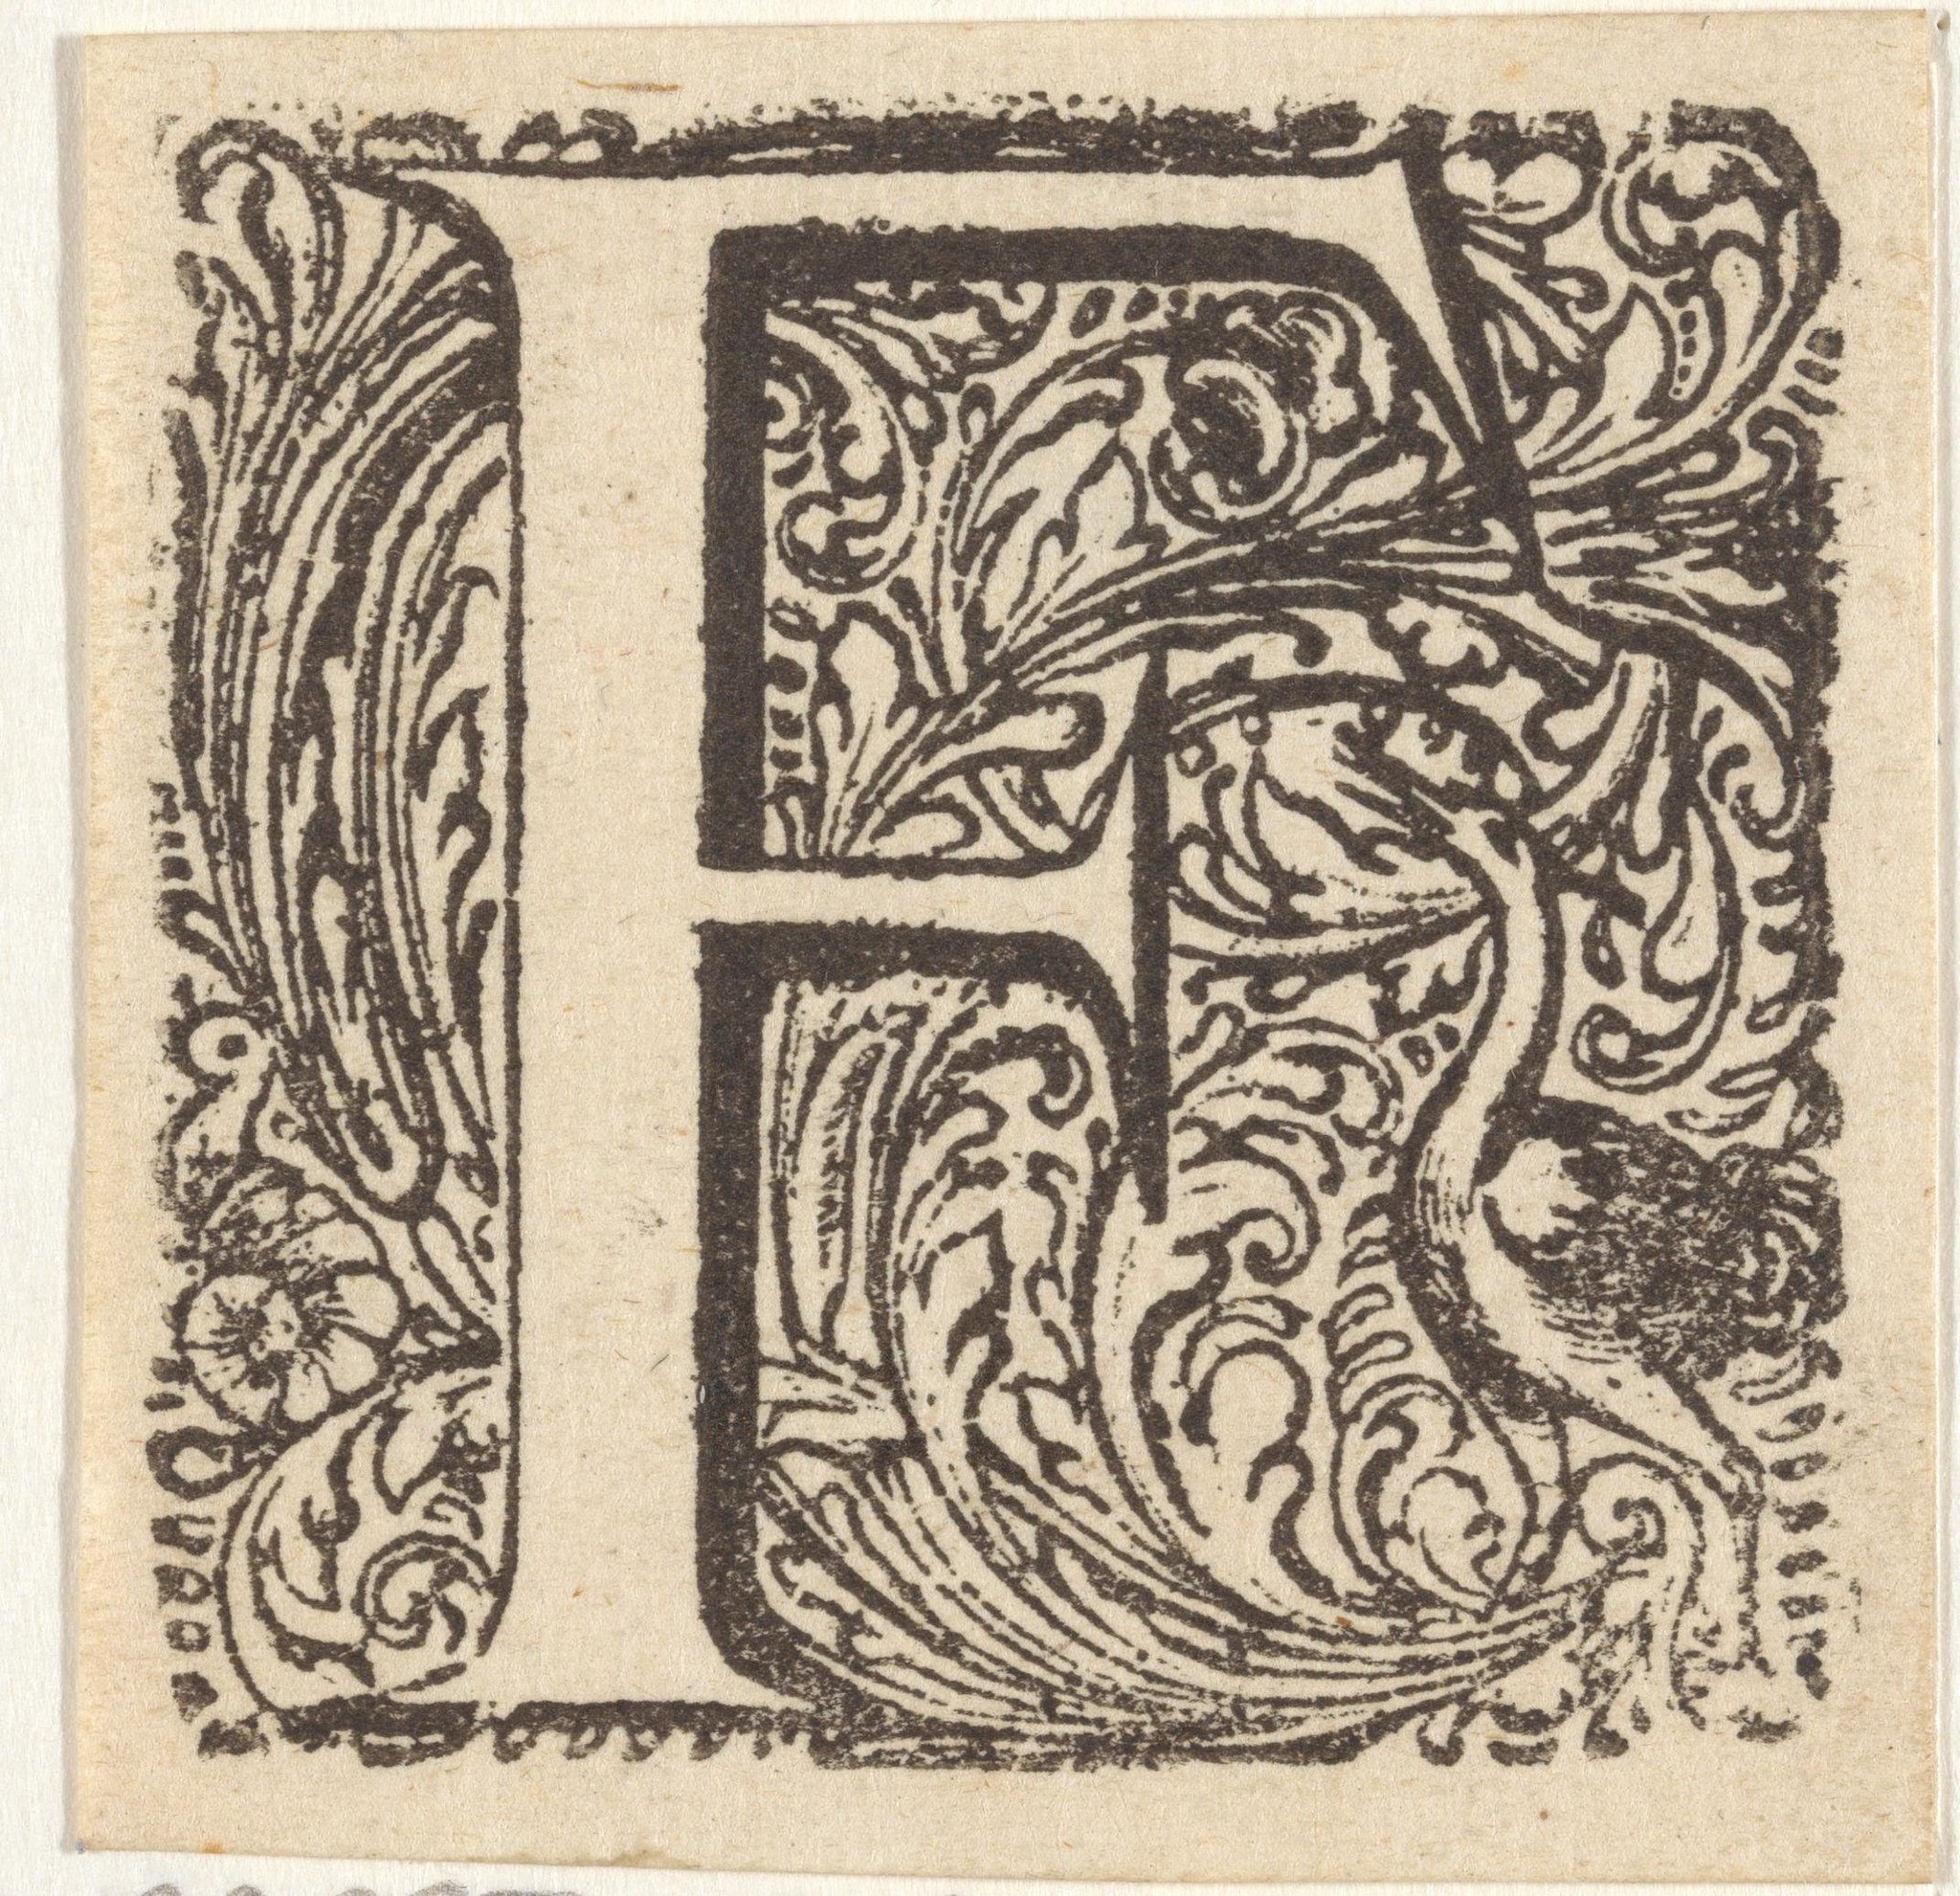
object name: print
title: Letter F in een omlijsting met een vogel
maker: Anonymous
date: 1600-1699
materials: paper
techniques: woodcut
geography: netherlands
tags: birds, fancy letters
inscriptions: collector's mark: Lugt 240